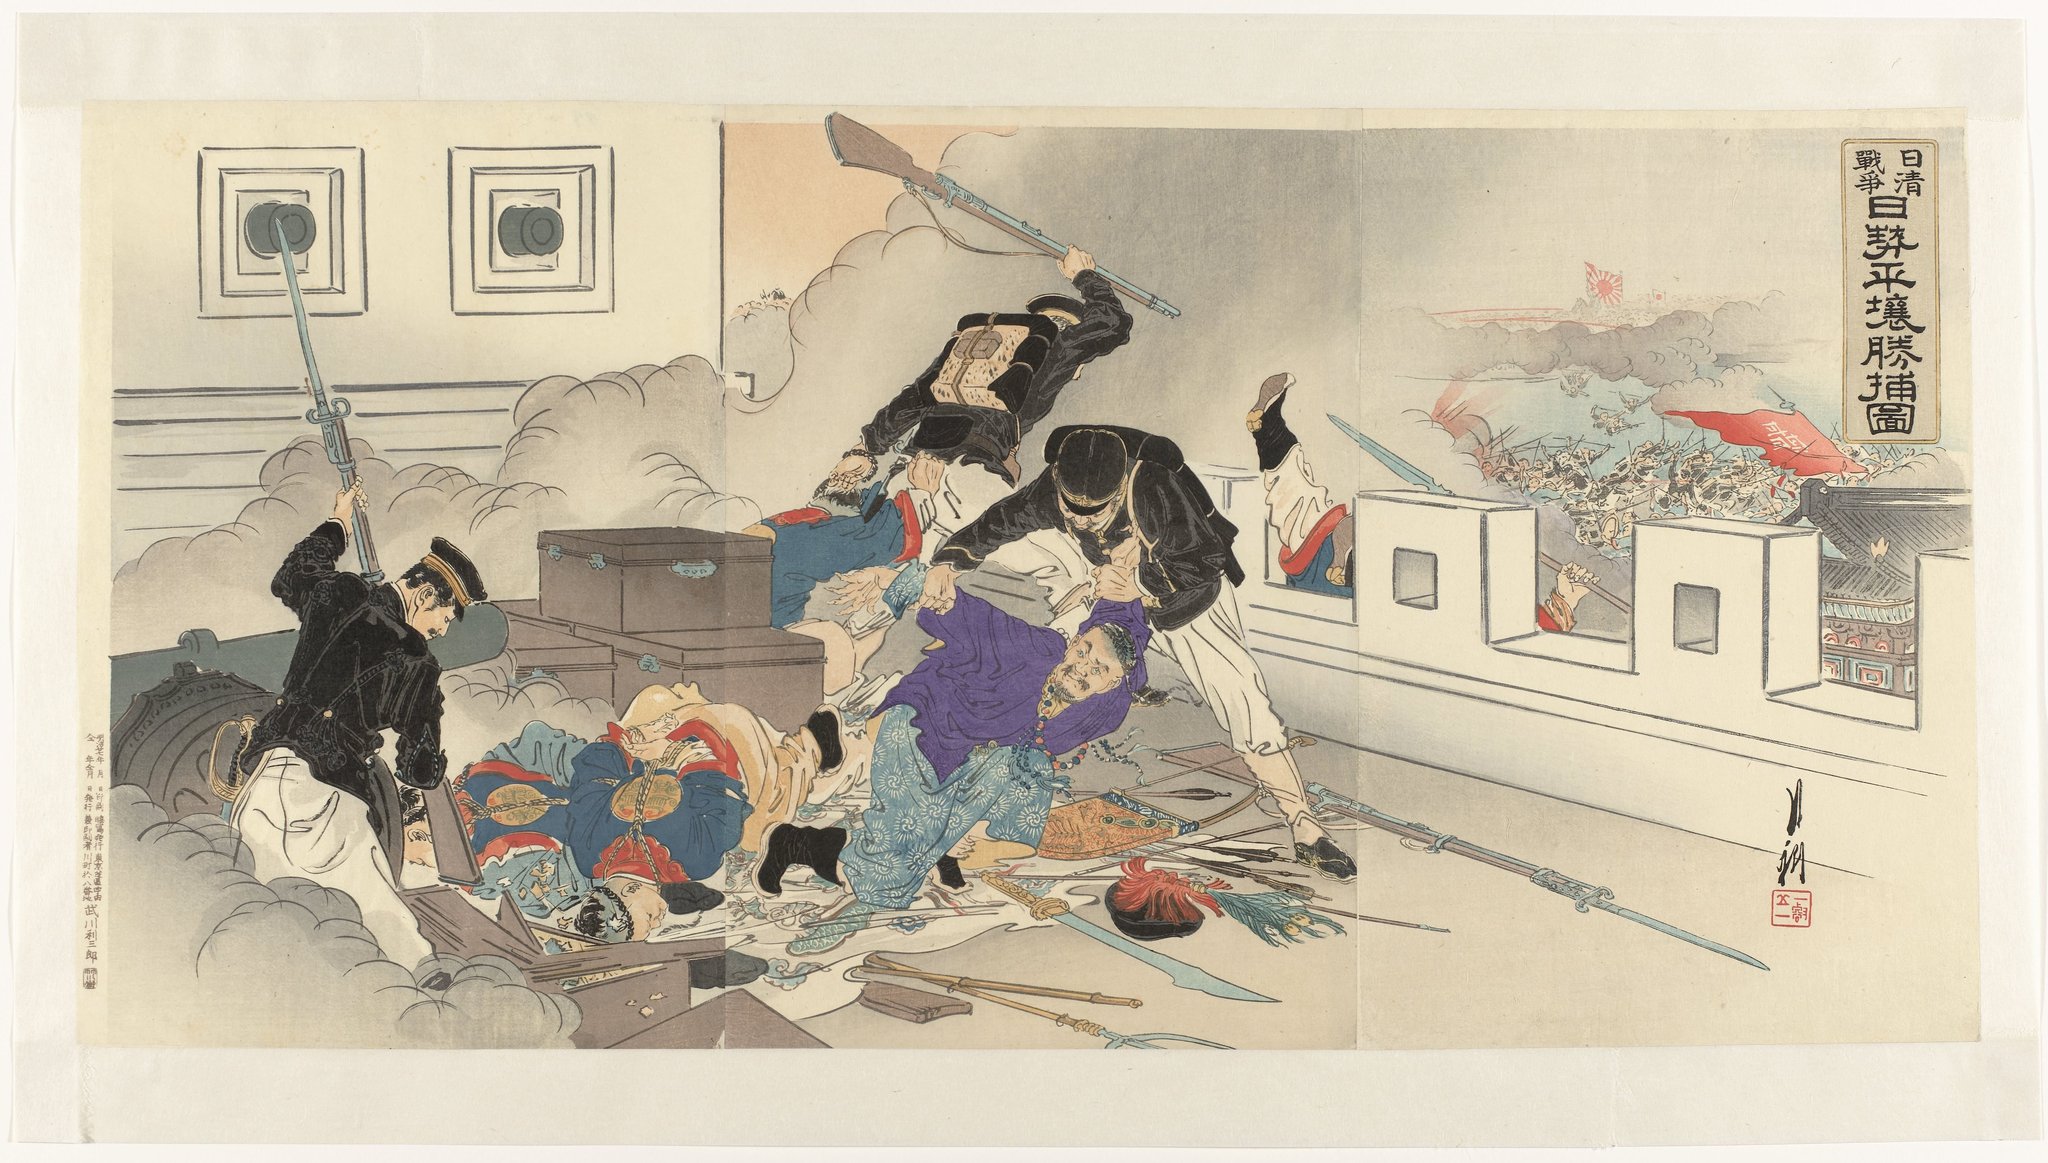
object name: print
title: Nisshin sensô Nissei Heijô shôho zu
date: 1894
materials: paper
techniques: woodcut, polish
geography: japan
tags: battle, plundering ~ soldiers, prisoner with hands bound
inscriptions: label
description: Japanse soldaten binden Koreaanse inwoners van Pyonyang vast en plunderen het huis. Op 15 september 1894 vielen de Japanse troepen de ommuurde stad binnen, de volgende dag gaf de stad zich volledig over. Dit gebeurde tijdens de Eerste Chinees-Japanse Oorlog (1894-1895).